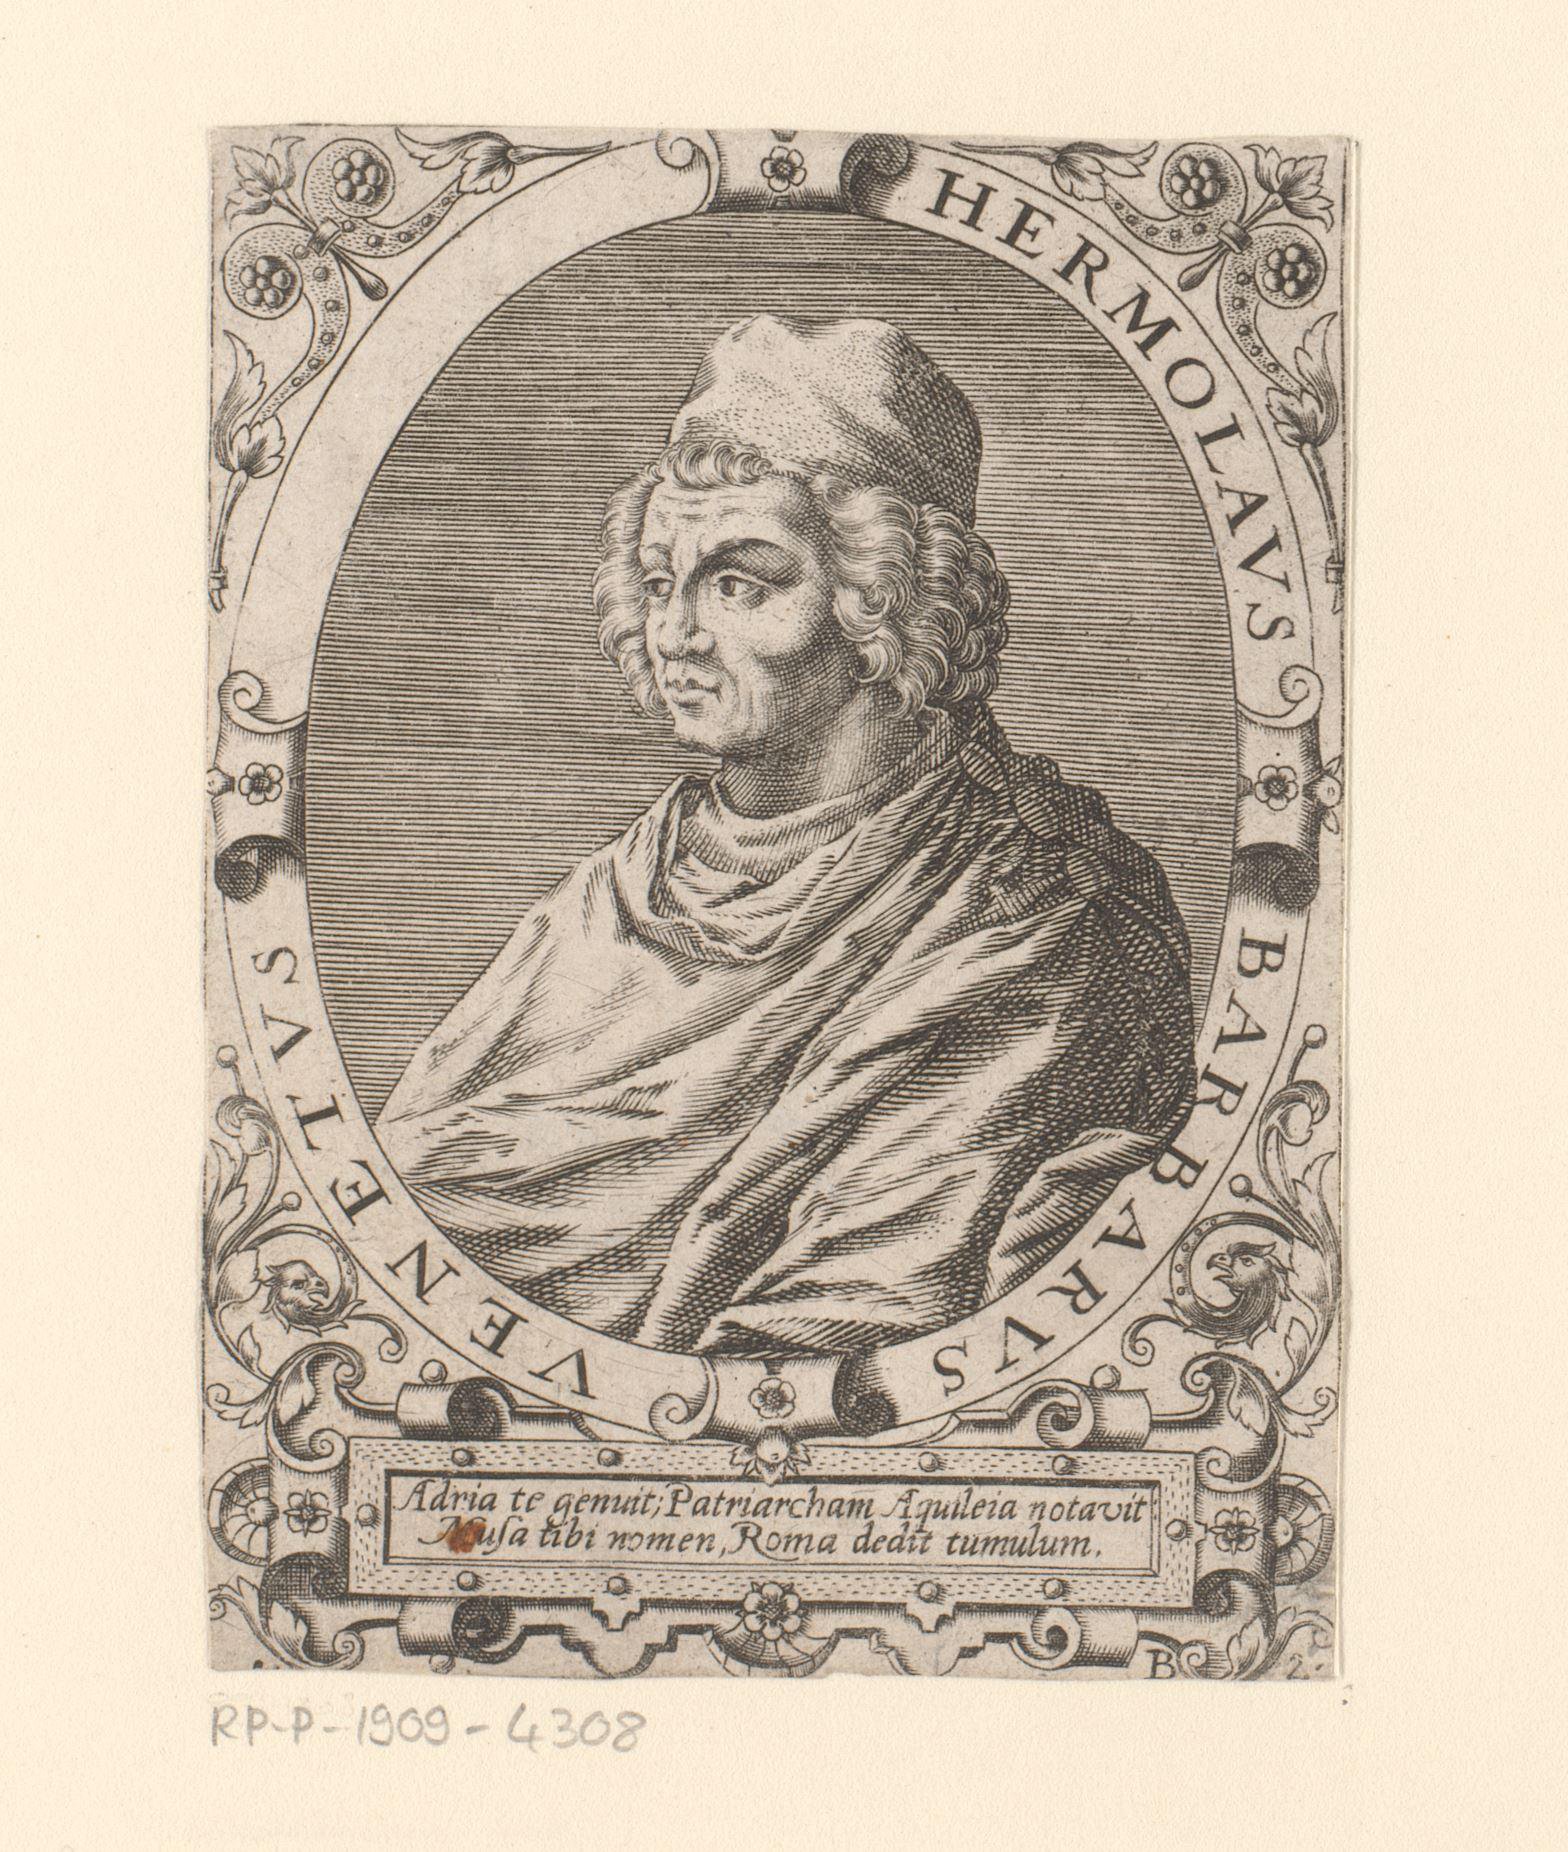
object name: book illustration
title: Hermolaus Barbarus Venetus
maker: jean jacques boissard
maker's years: 1528-1598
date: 1669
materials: paper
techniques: engraving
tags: venice, priest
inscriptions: collector's mark: Lugt 2228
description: Gemaakt voor: J.J. Boissard, Icones virorum illustrium doctrina &c eruditione praestanti um contines. Frankfurt am Main: de Bry, 1597-1599. Opnieuw gebruikt in: J.J.Boissard, Bibliotheca chalcographica, hoc est Virtute et eruditione clarorum Virorum Imagines. Heidelberg: Clemens Ammon, 1669. Dl. 1-5 (te herkennen aan de toegevoegde signatuur in de rechter onderhoek: B2).